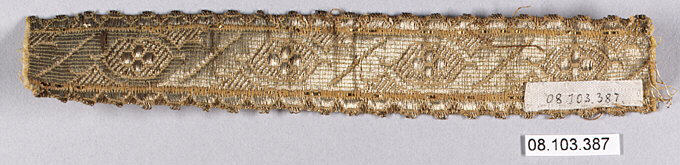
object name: galloon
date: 1601-1800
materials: metal thread